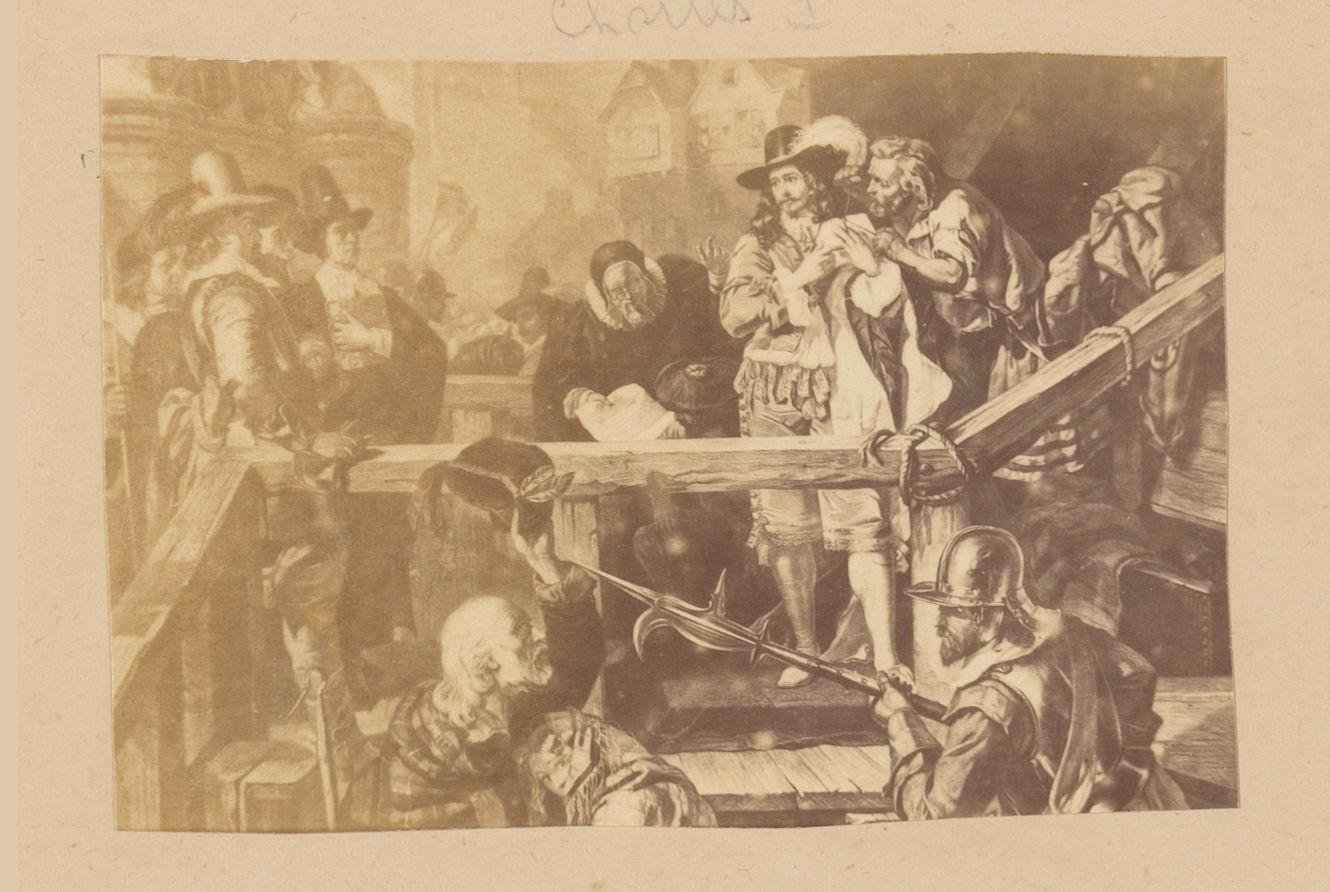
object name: album leaf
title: Fotoreproductie van een schilderij met vermoedelijk Karel I van Engeland en een man die naar het schavot wordt geleid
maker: Anonymous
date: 1875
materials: paper, photographic support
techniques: albumen print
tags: karel i (koning van engeland), on the scaffold or place of execution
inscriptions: name: ‘Charles 1’